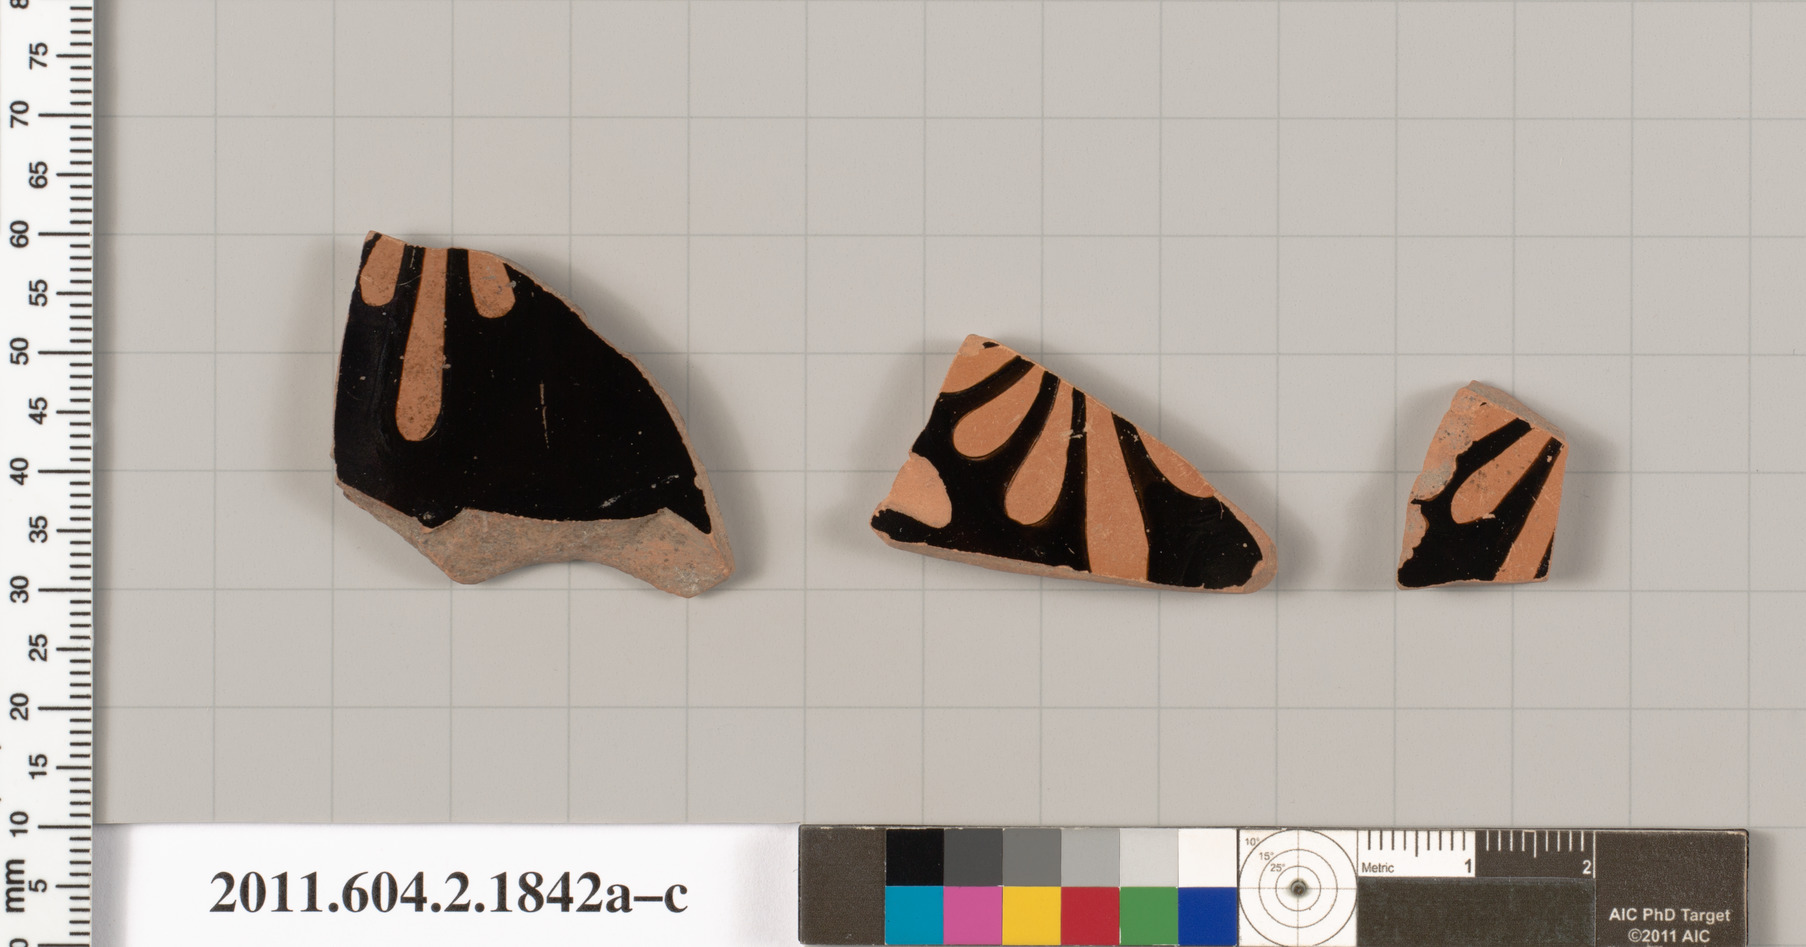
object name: skyphos fragment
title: Terracotta fragments of skyphoi (deep drinking cups)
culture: greek, attic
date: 450-426 BCE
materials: terracotta